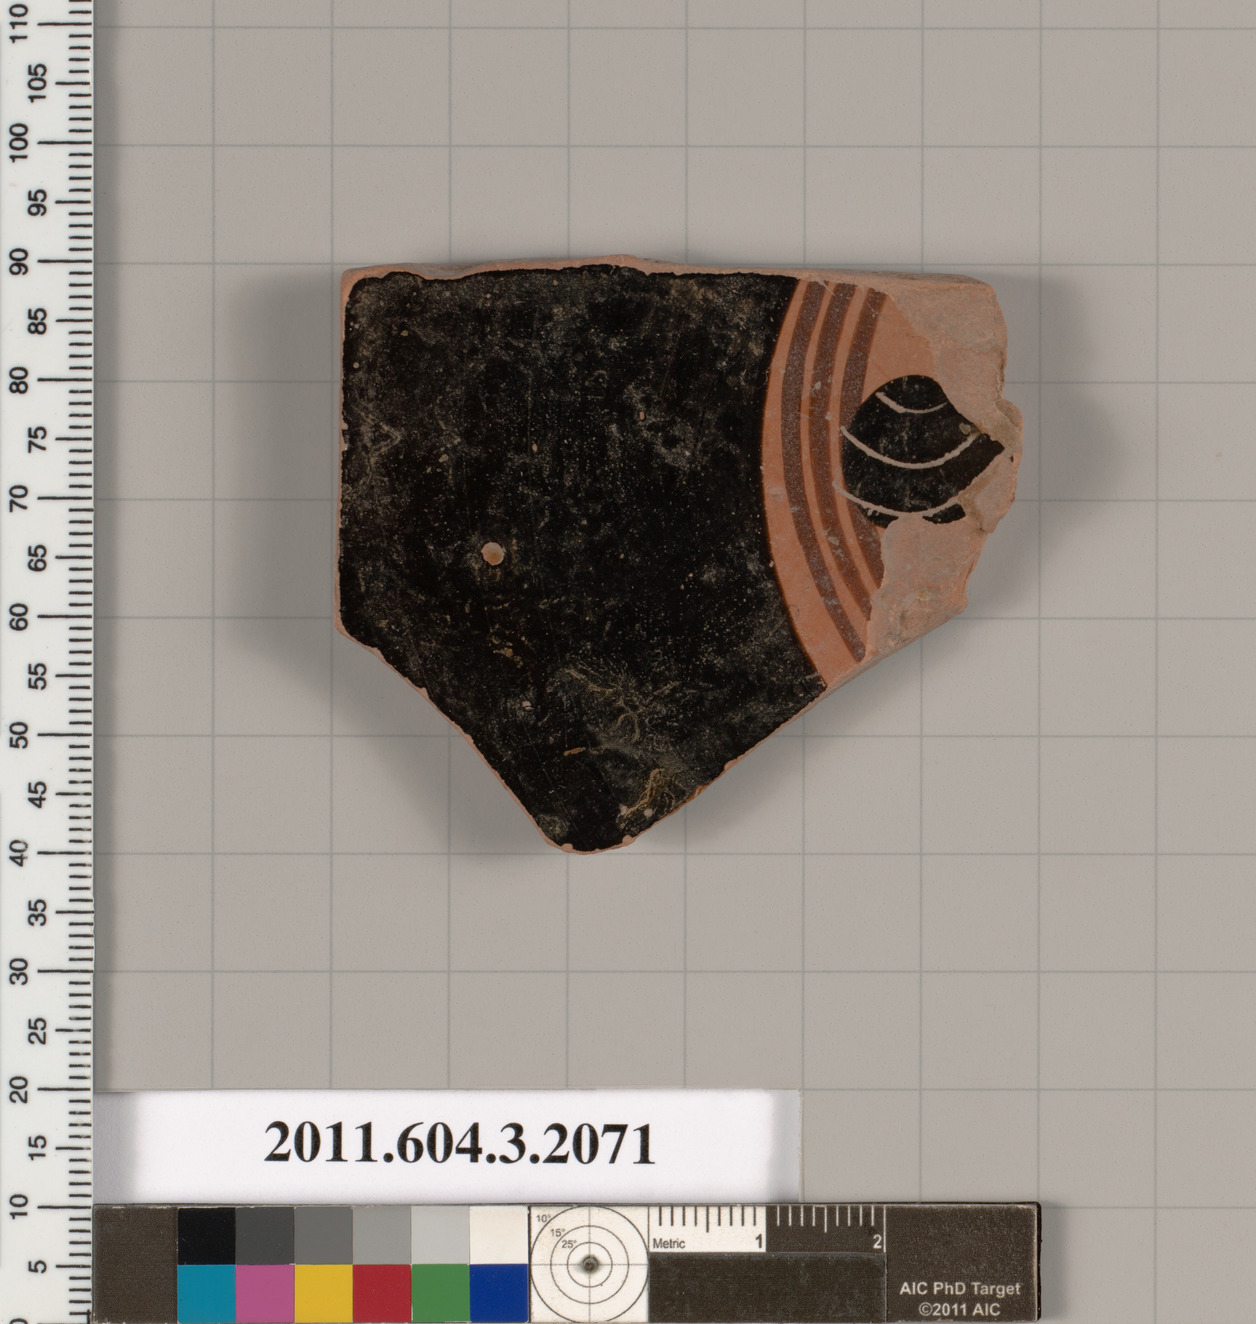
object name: kylix fragment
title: Terracotta fragment of a kylix (drinking cup)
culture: greek, attic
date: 500-468 BCE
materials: terracotta